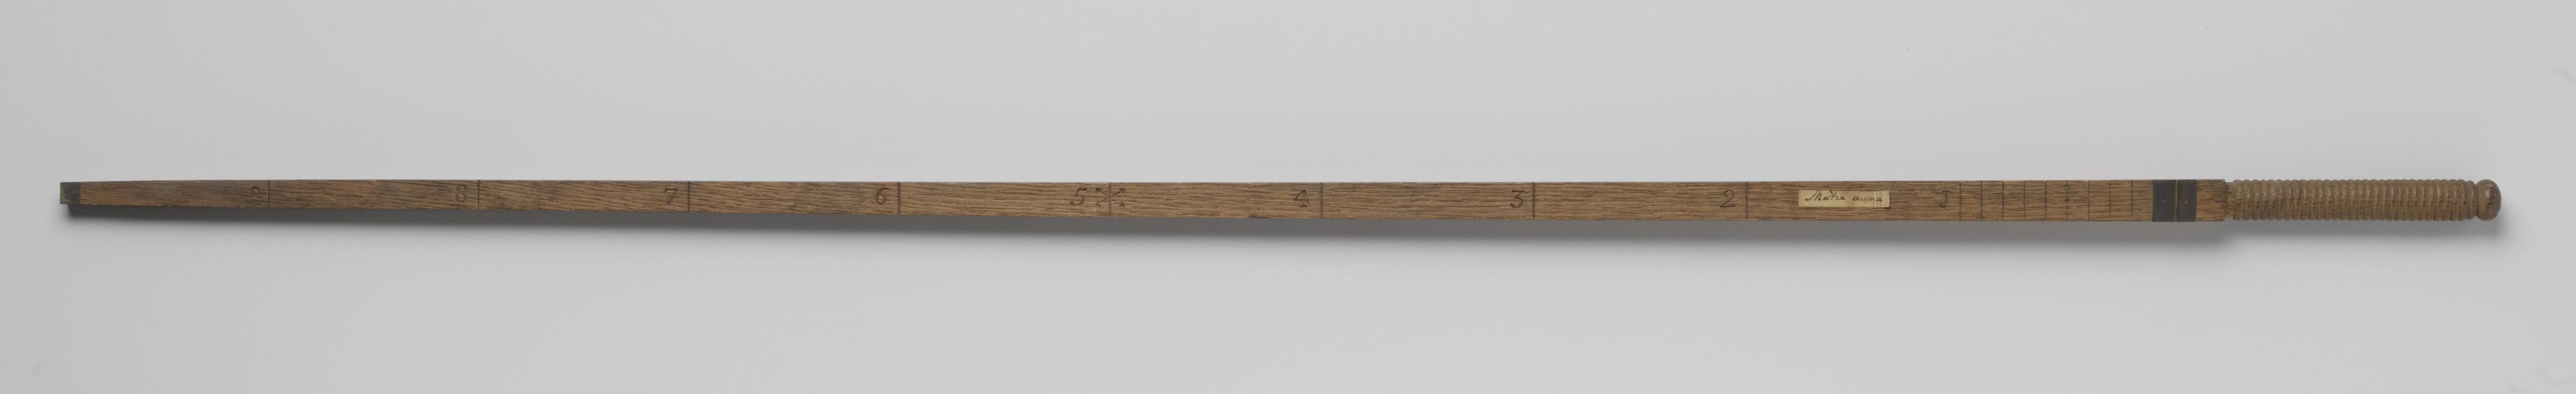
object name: meter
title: Meter met handvat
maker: Anonymous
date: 1820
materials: brass, wood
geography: netherlands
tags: netherlands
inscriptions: inscription: ‘Mètre aune’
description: Meter met verdeling en becijfering in decimeters. Eerste decimeter in centimeters. V.z.v. etiket.